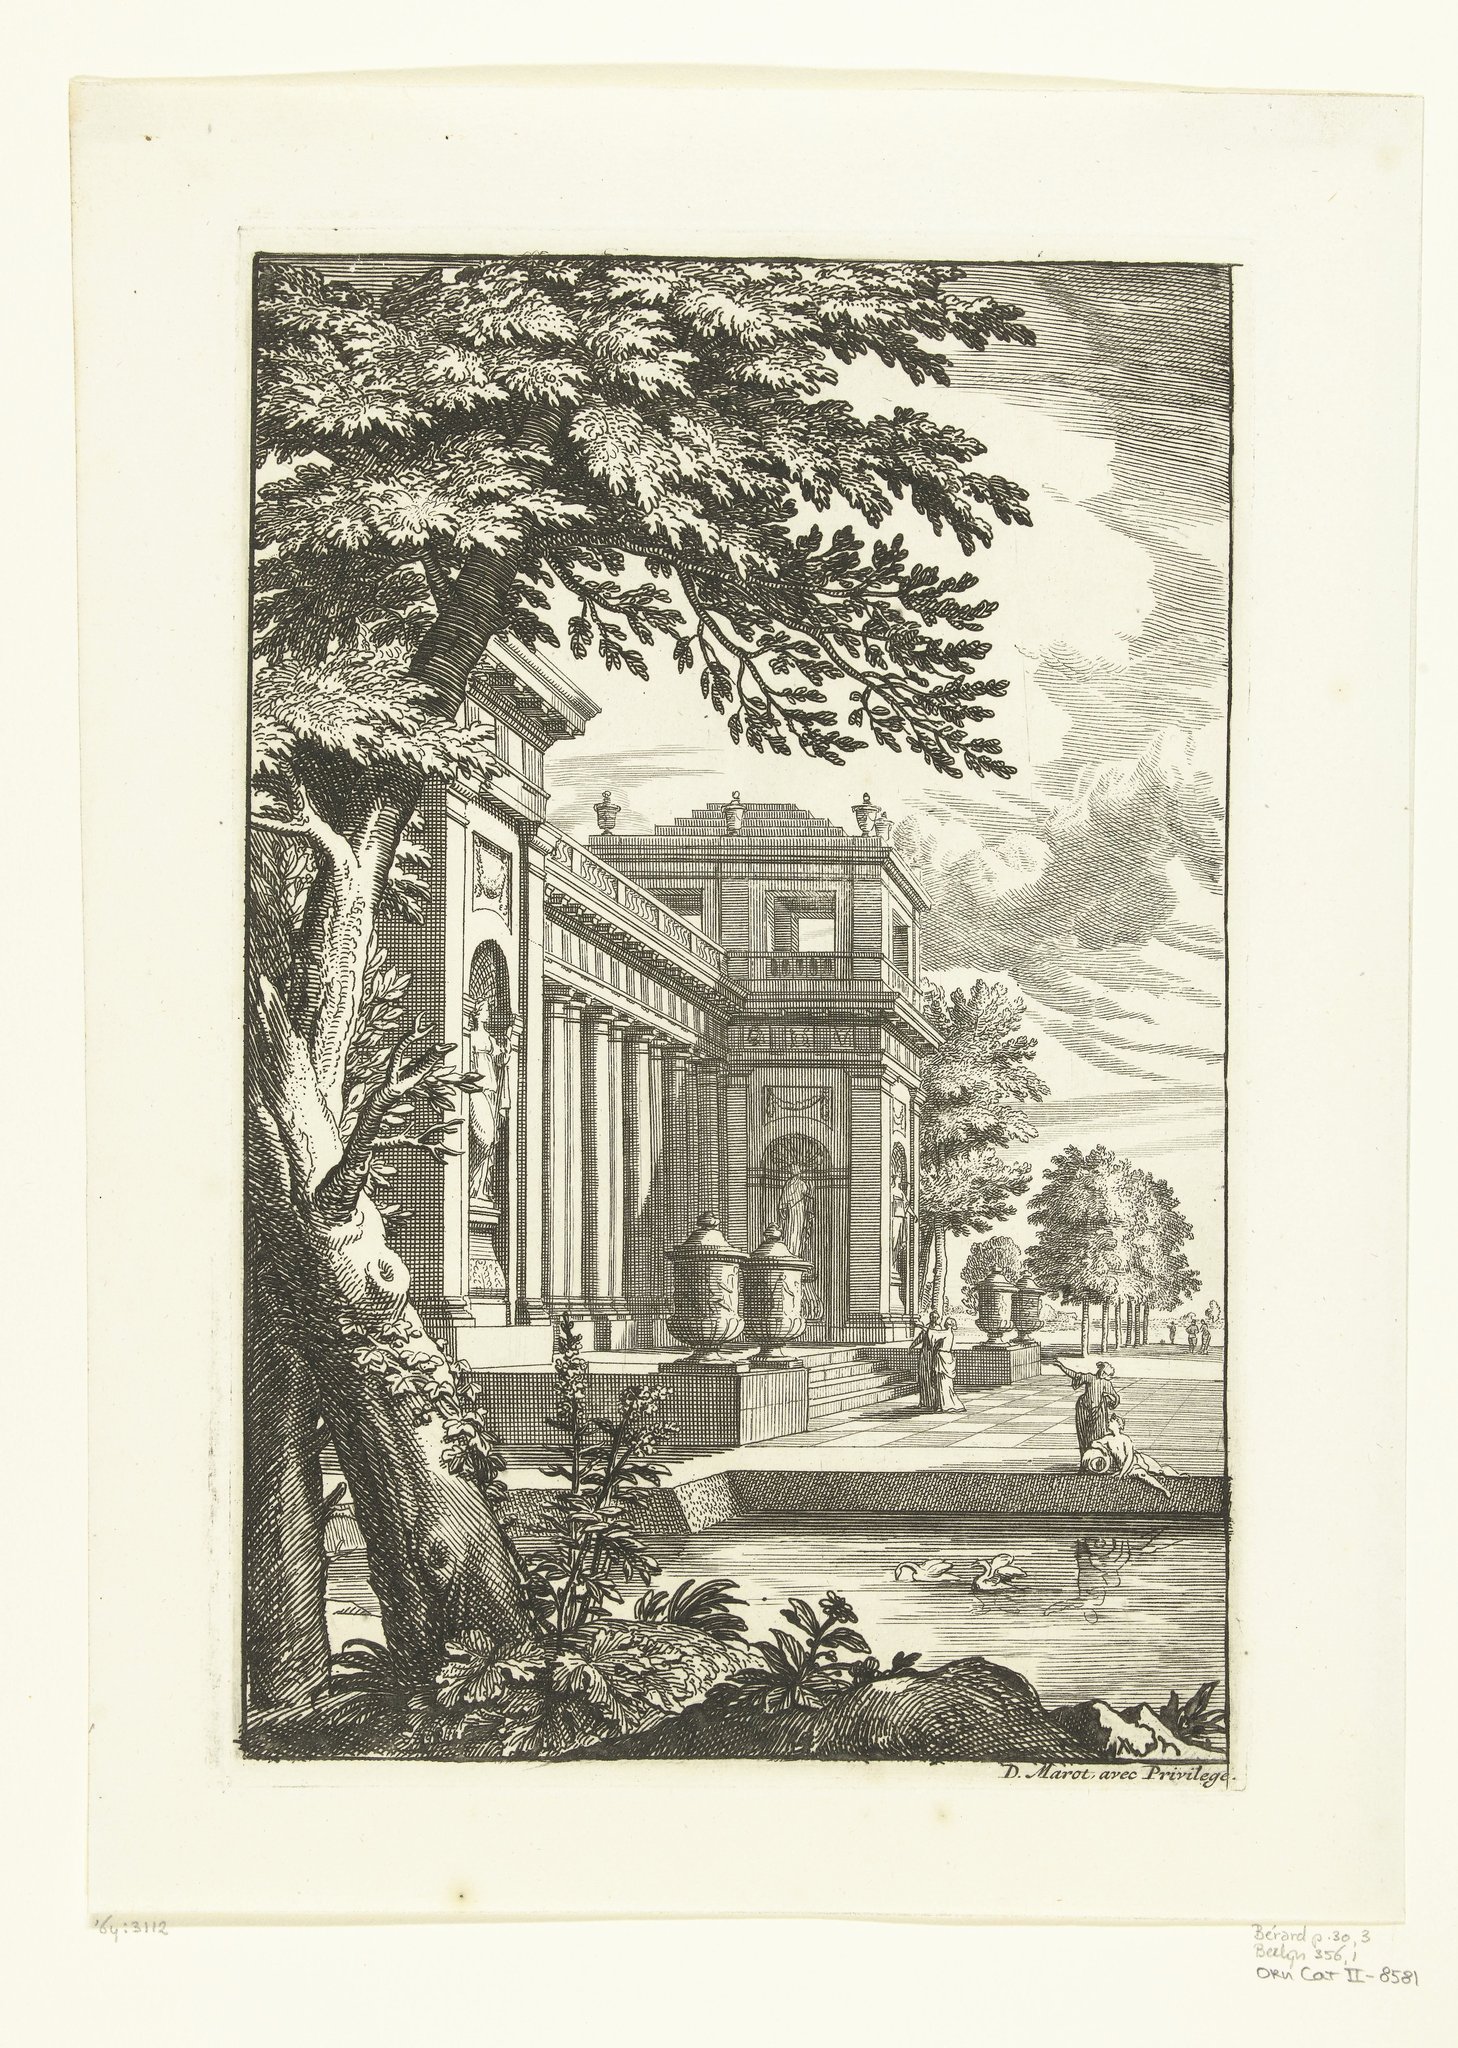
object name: print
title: Gevel van paleis met vijver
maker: daniël marot (i)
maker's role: draughtsman, print maker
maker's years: 1661-1752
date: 1703-1712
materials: paper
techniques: etching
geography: netherlands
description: Links staan twee bomen. Uit serie van 6 bladen.